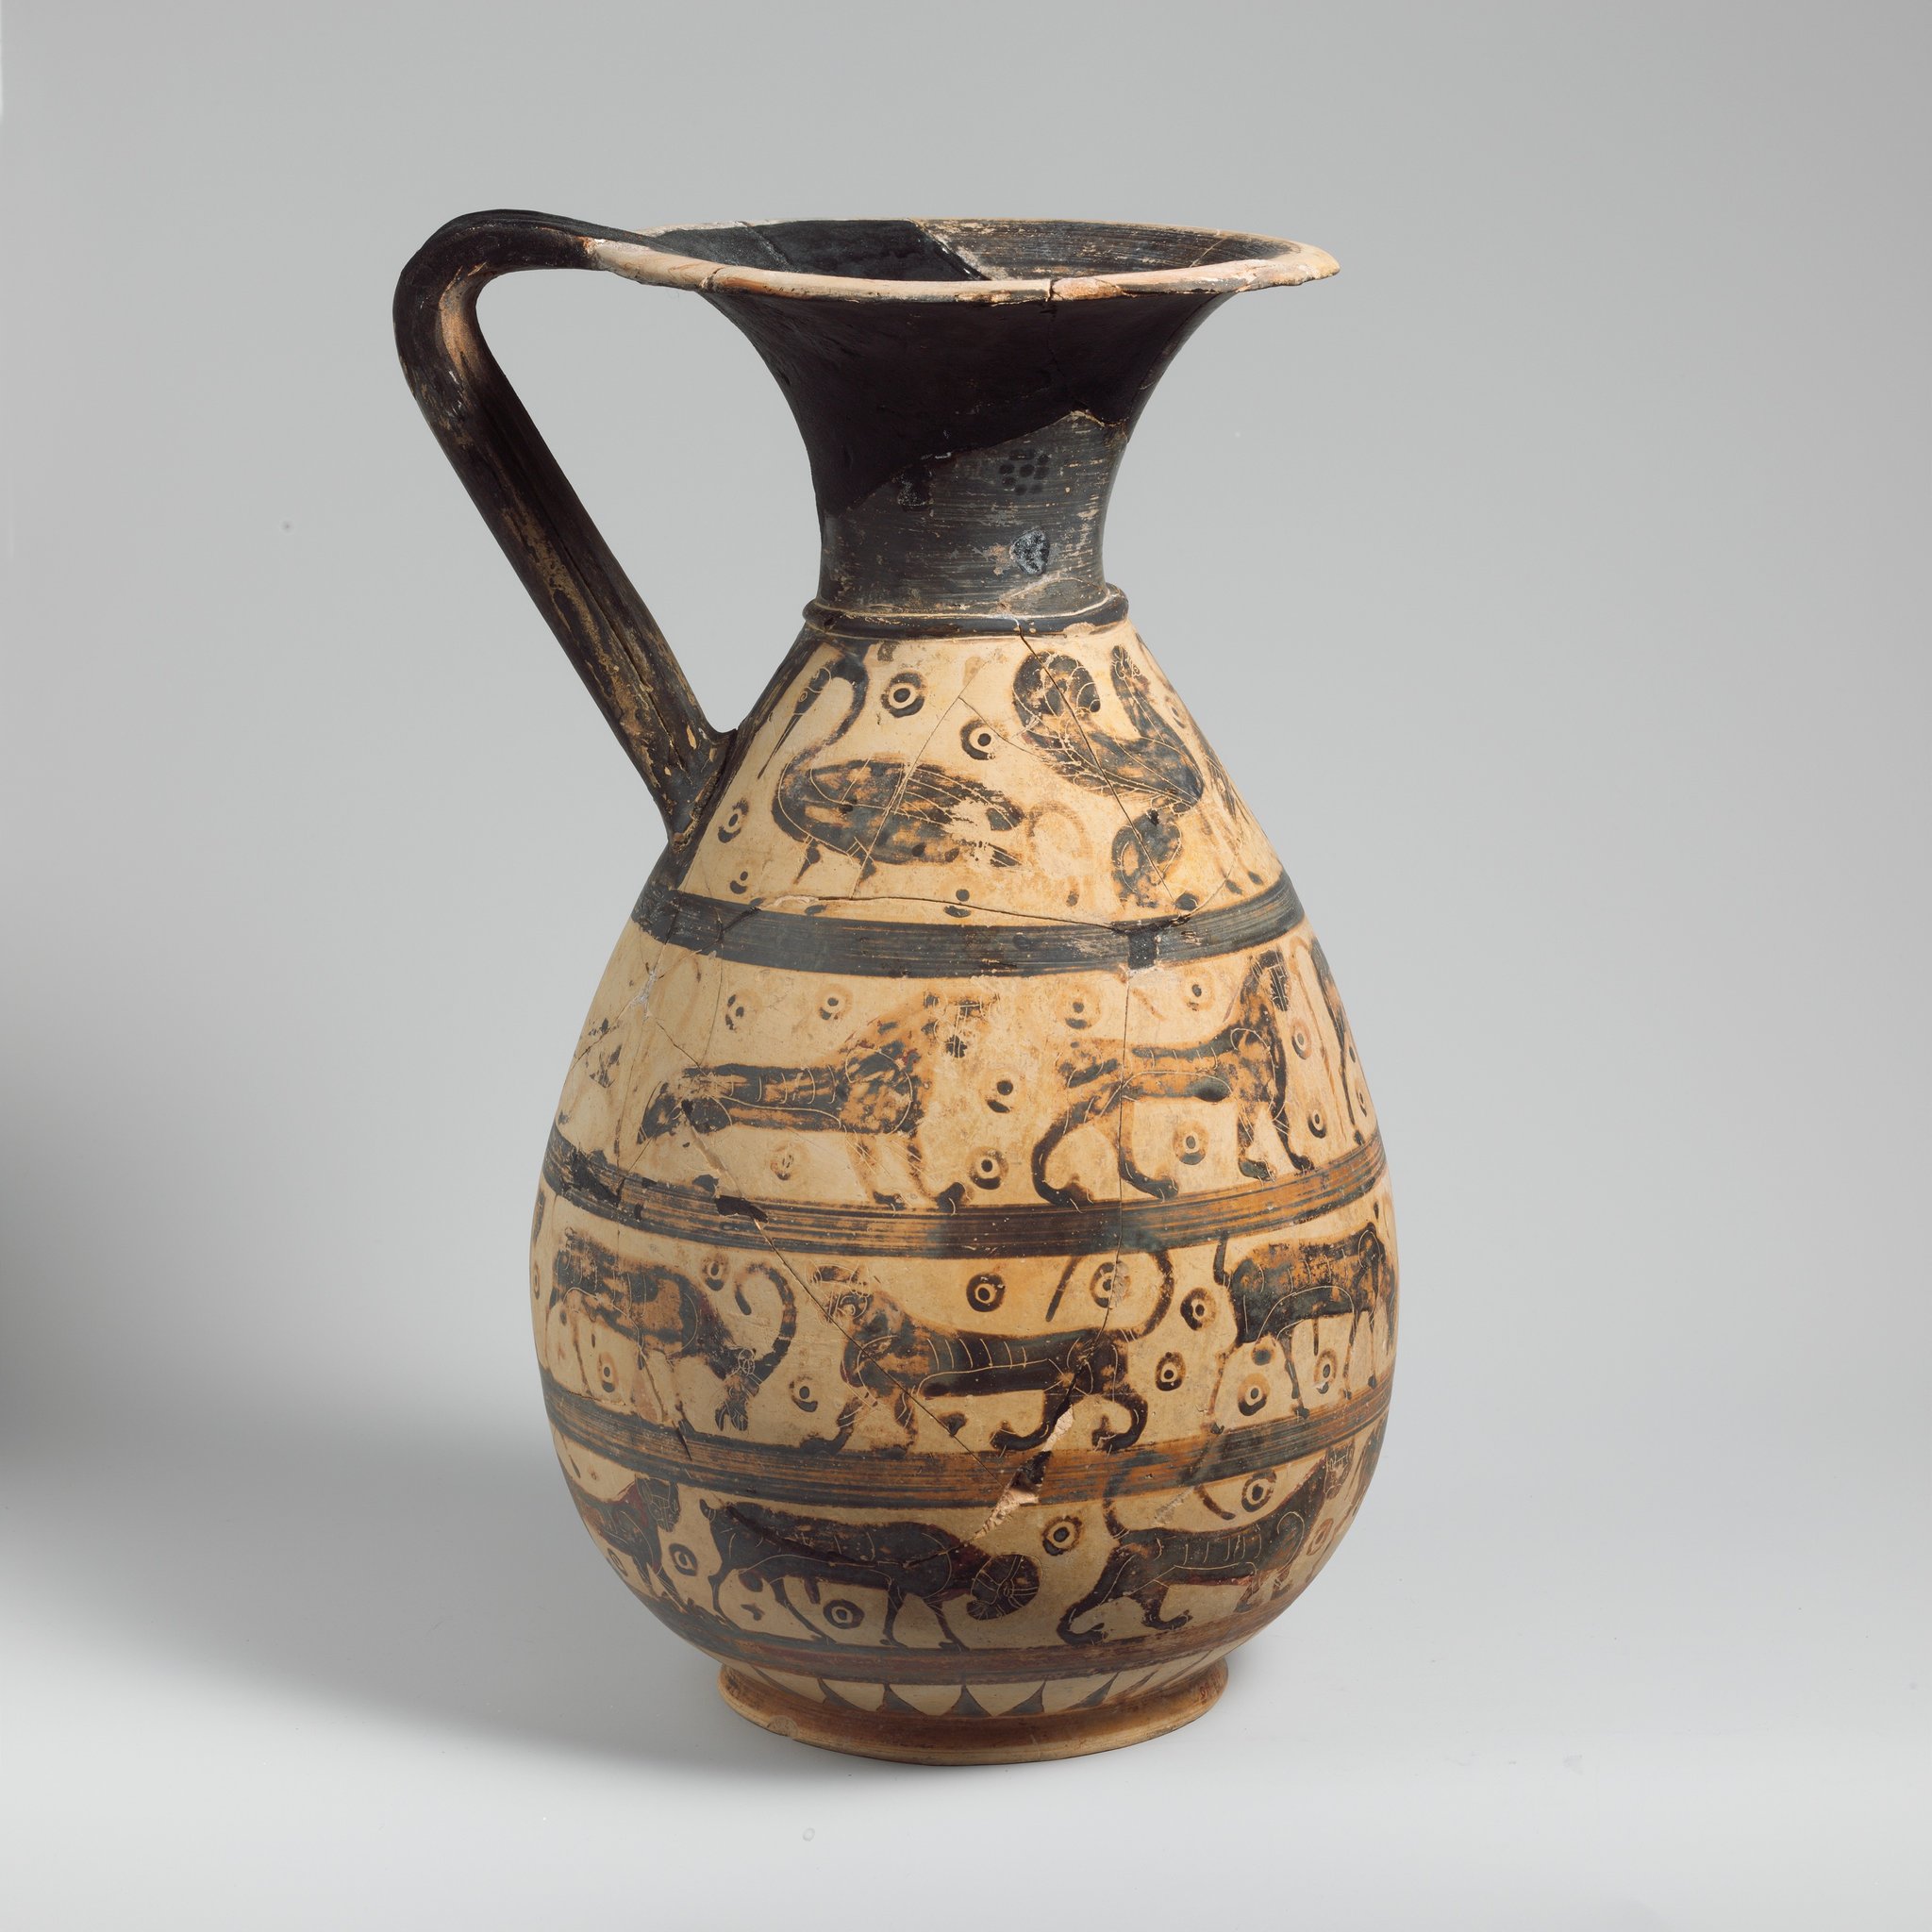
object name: olpe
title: Terracotta oinochoe:olpe (jug)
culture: greek, corinthian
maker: milazzo painter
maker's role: artist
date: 630-615 BCE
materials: terracotta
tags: animals,birds